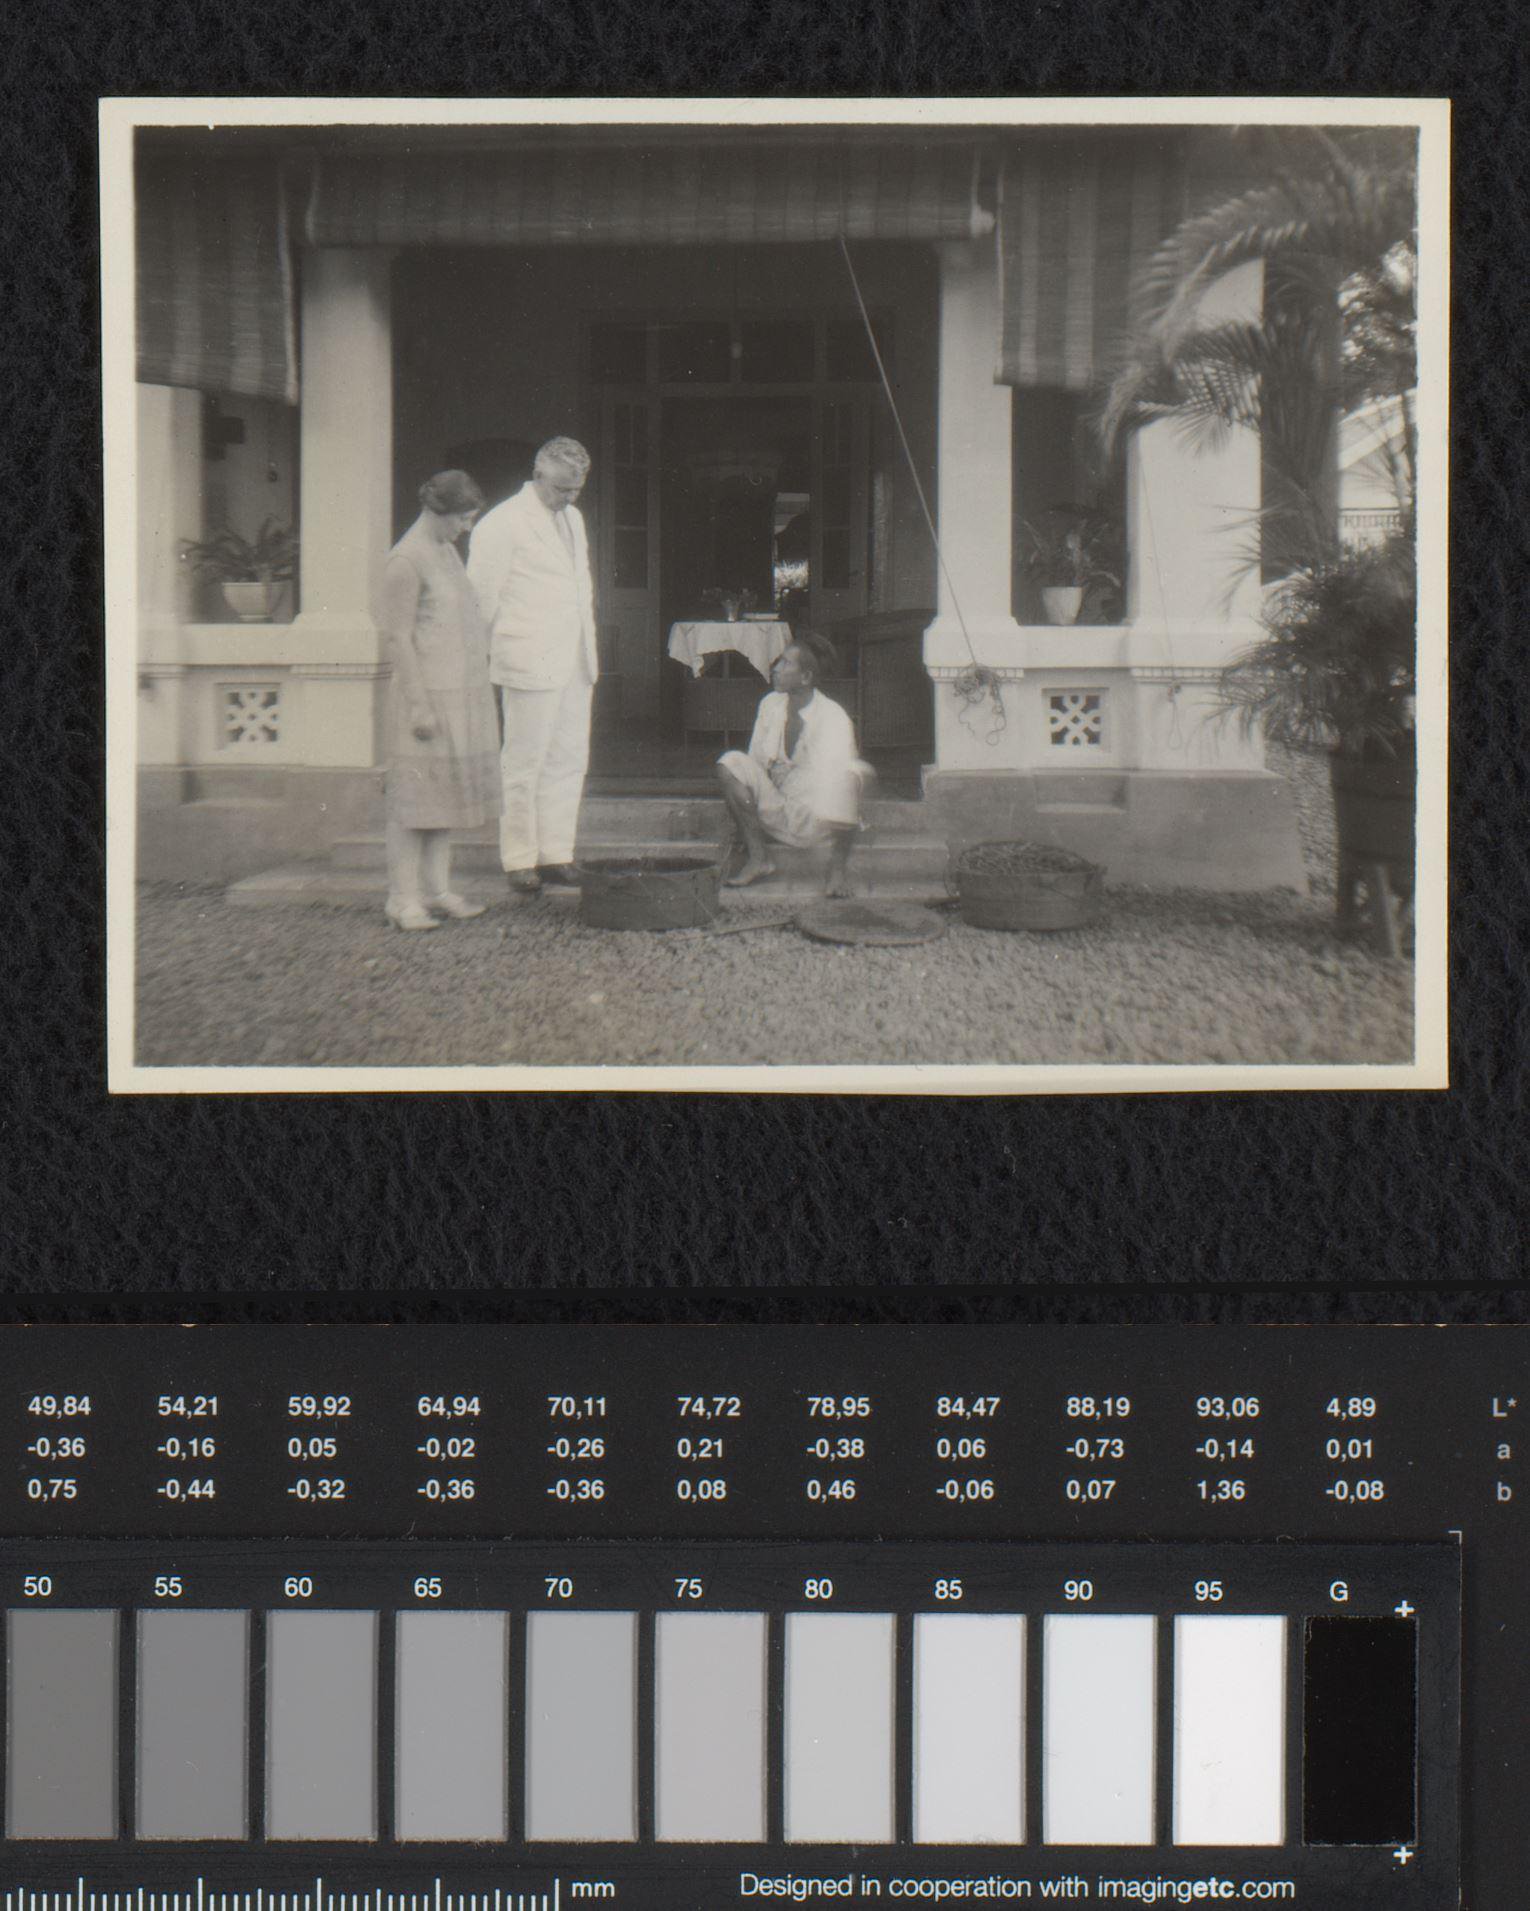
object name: photograph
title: Machteld en Martinus in Weltevreden, 1930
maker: Anonymous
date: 1930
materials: photographic support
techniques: gelatin silver print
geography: weltevreden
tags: rotterdam, arnhem, machteld anna cornelia honig, sea and coastal fishery (+ men (labourers)), colonial government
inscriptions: inscription: ‘Weltevreden 1930. Machteld en Mar aan 't pingelen bij den vischboer’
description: Machteld Honig en haar man bij een visboer in Weltevreden in Batavia, 1930. Losse foto behorend bij het fotoalbum van Machteld Anna Cornelia Honig met foto's van Sumatra in de periode 1929-1933.